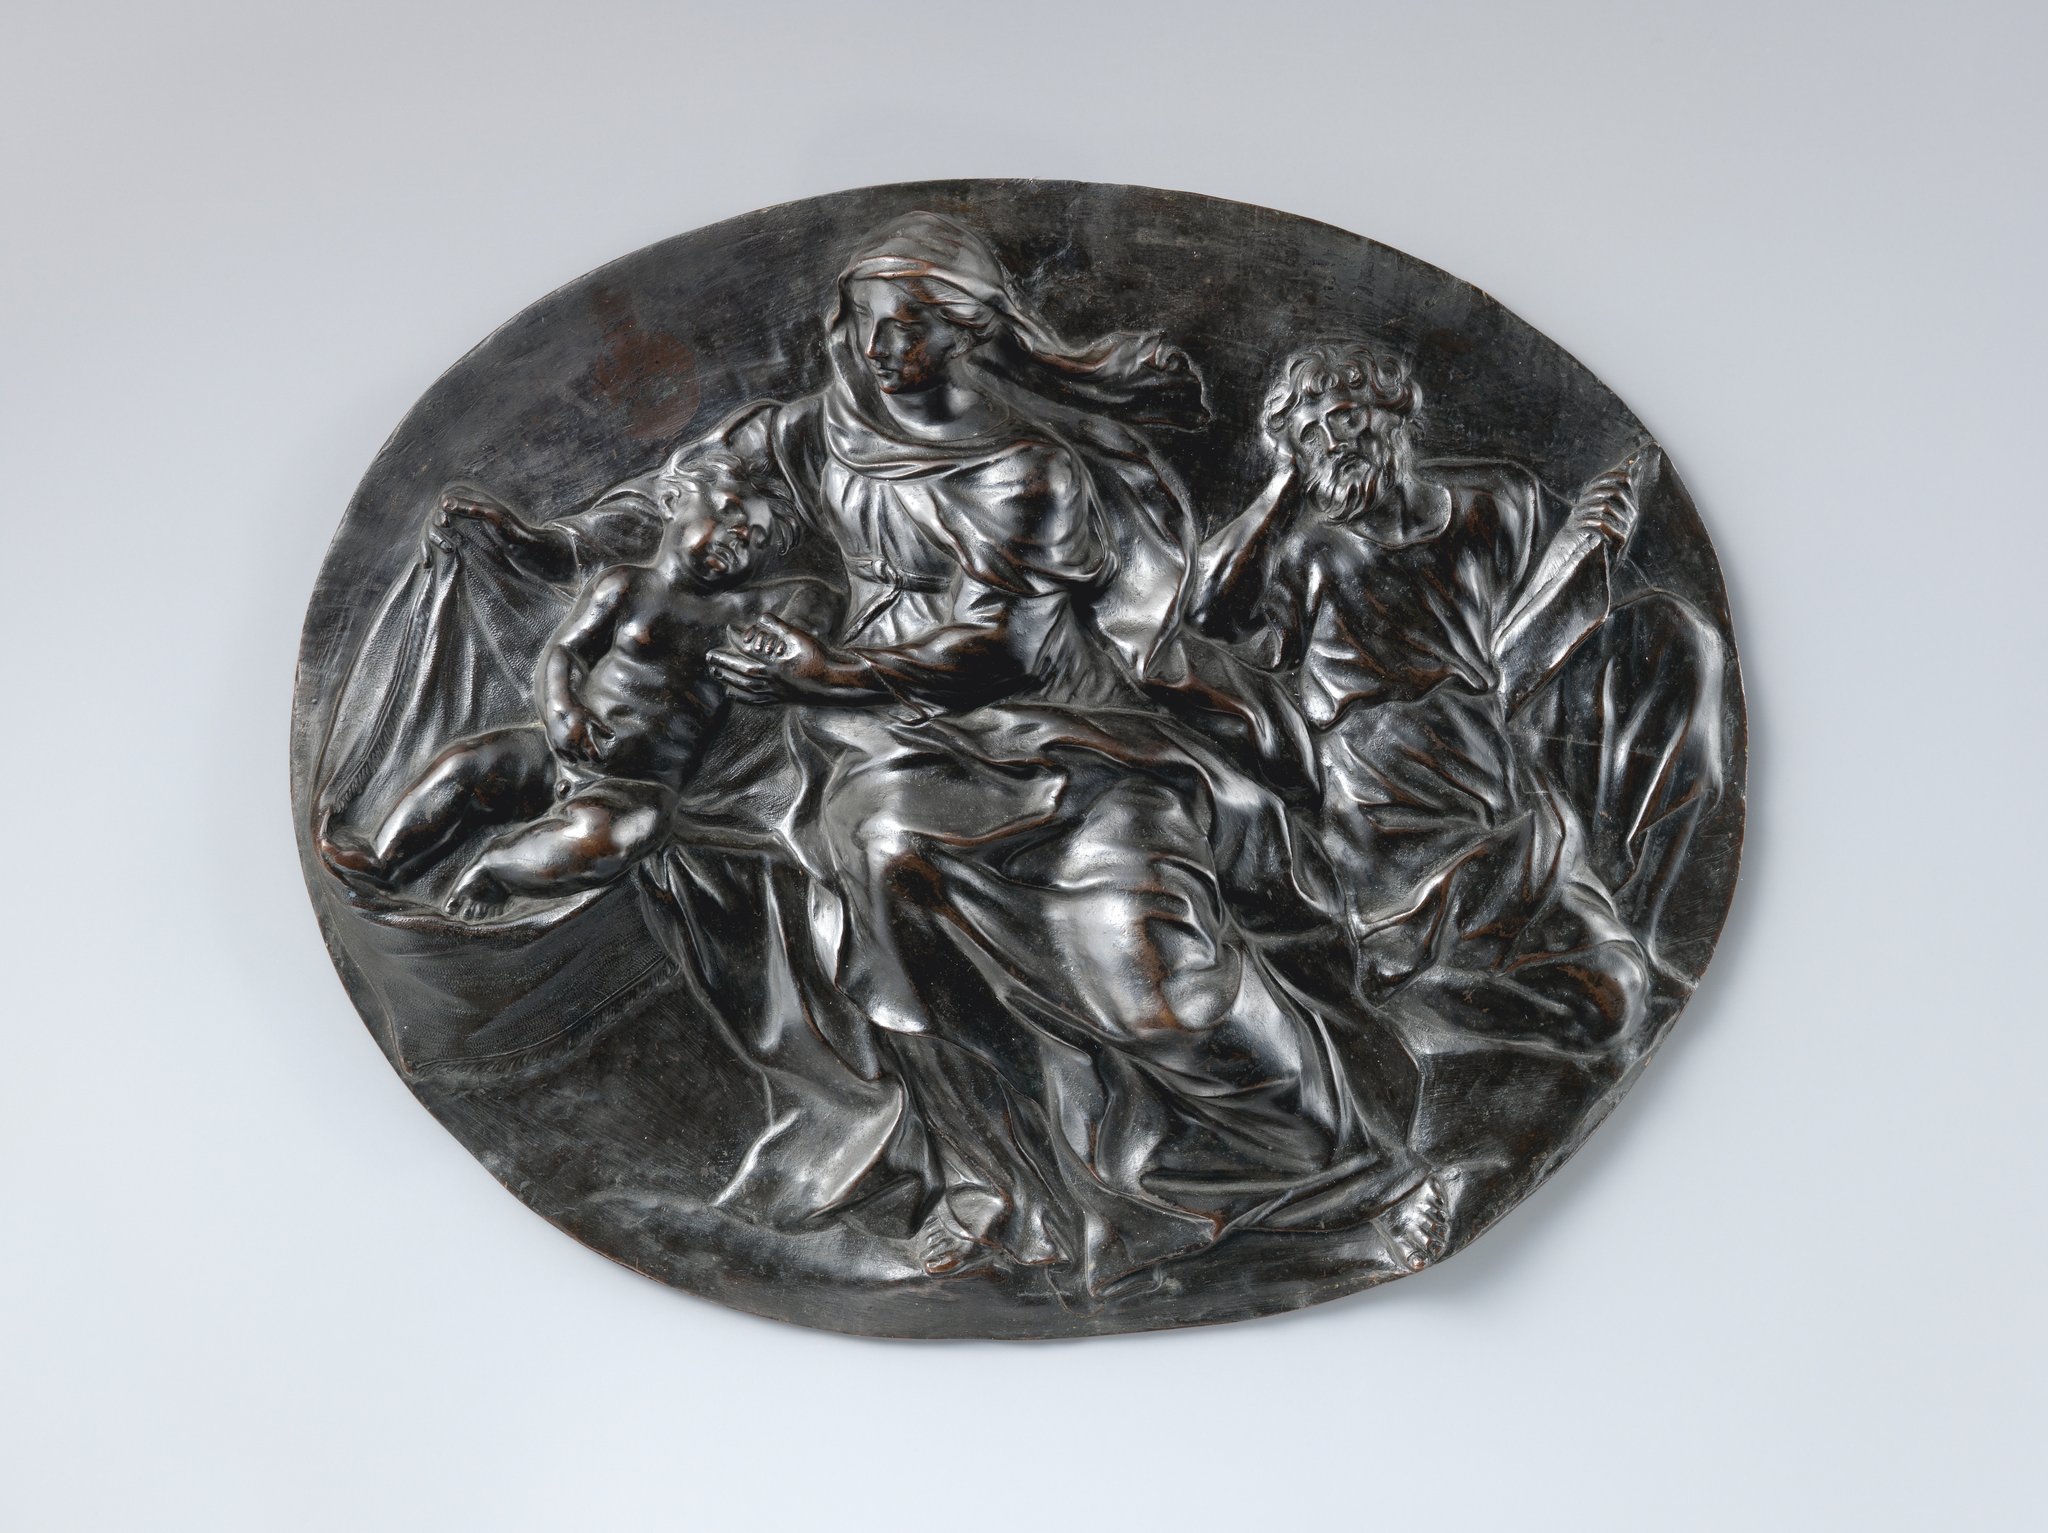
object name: plaque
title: The rest on the flight into Egypt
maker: alessandro algardi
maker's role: artist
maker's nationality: italian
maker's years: 1598-1654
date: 1667-1700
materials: bronze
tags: holy family,flight into egypt